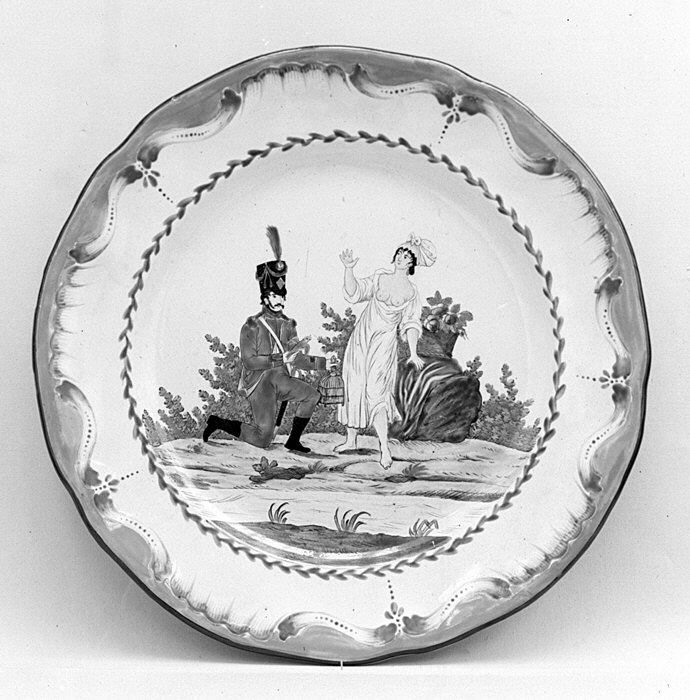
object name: plate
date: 1815-1825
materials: faience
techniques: glazing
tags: birds,men,women,plants